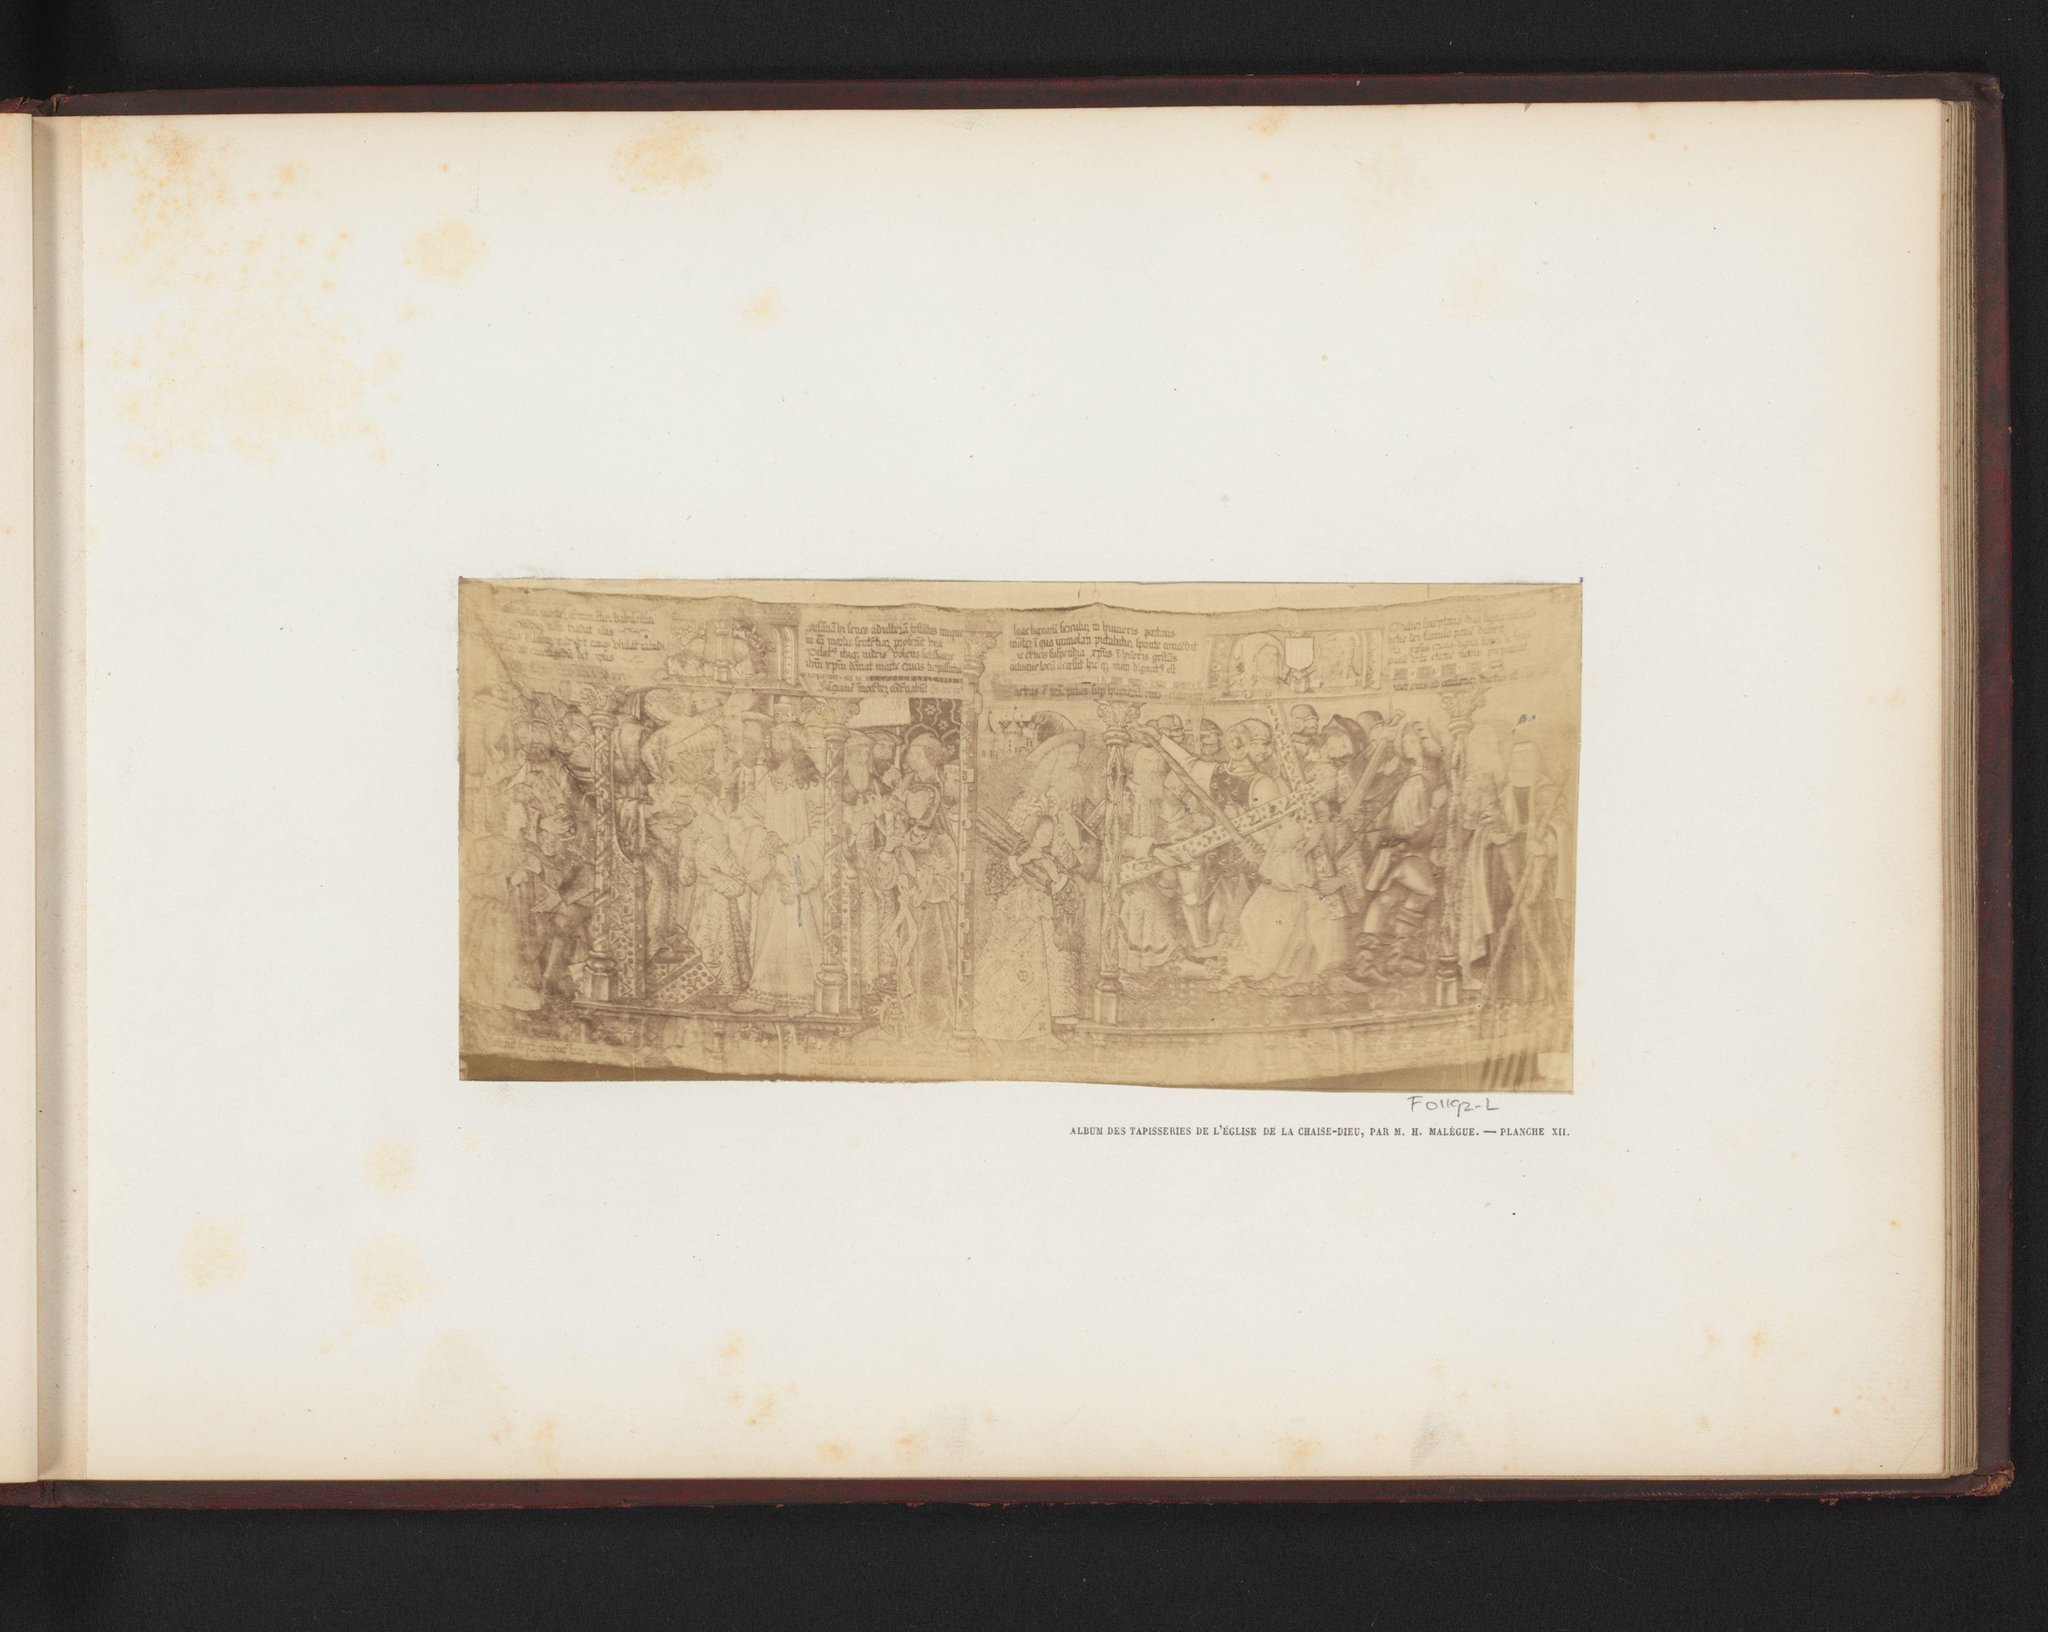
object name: photograph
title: Tapijt met Christus voor Pilatus, kruisdraging en prefiguraties in een kerk te La Chaise-Dieu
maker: hippolyte malègue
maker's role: archeoloog, fotograaf, schrijver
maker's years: 1825-1901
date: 1868-1873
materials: photographic support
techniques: albumen print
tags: tapestry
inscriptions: inscription: ‘album des tapisseries de l'église de la Chaise-Dieu, par M. H. Malegue - Planche XII’